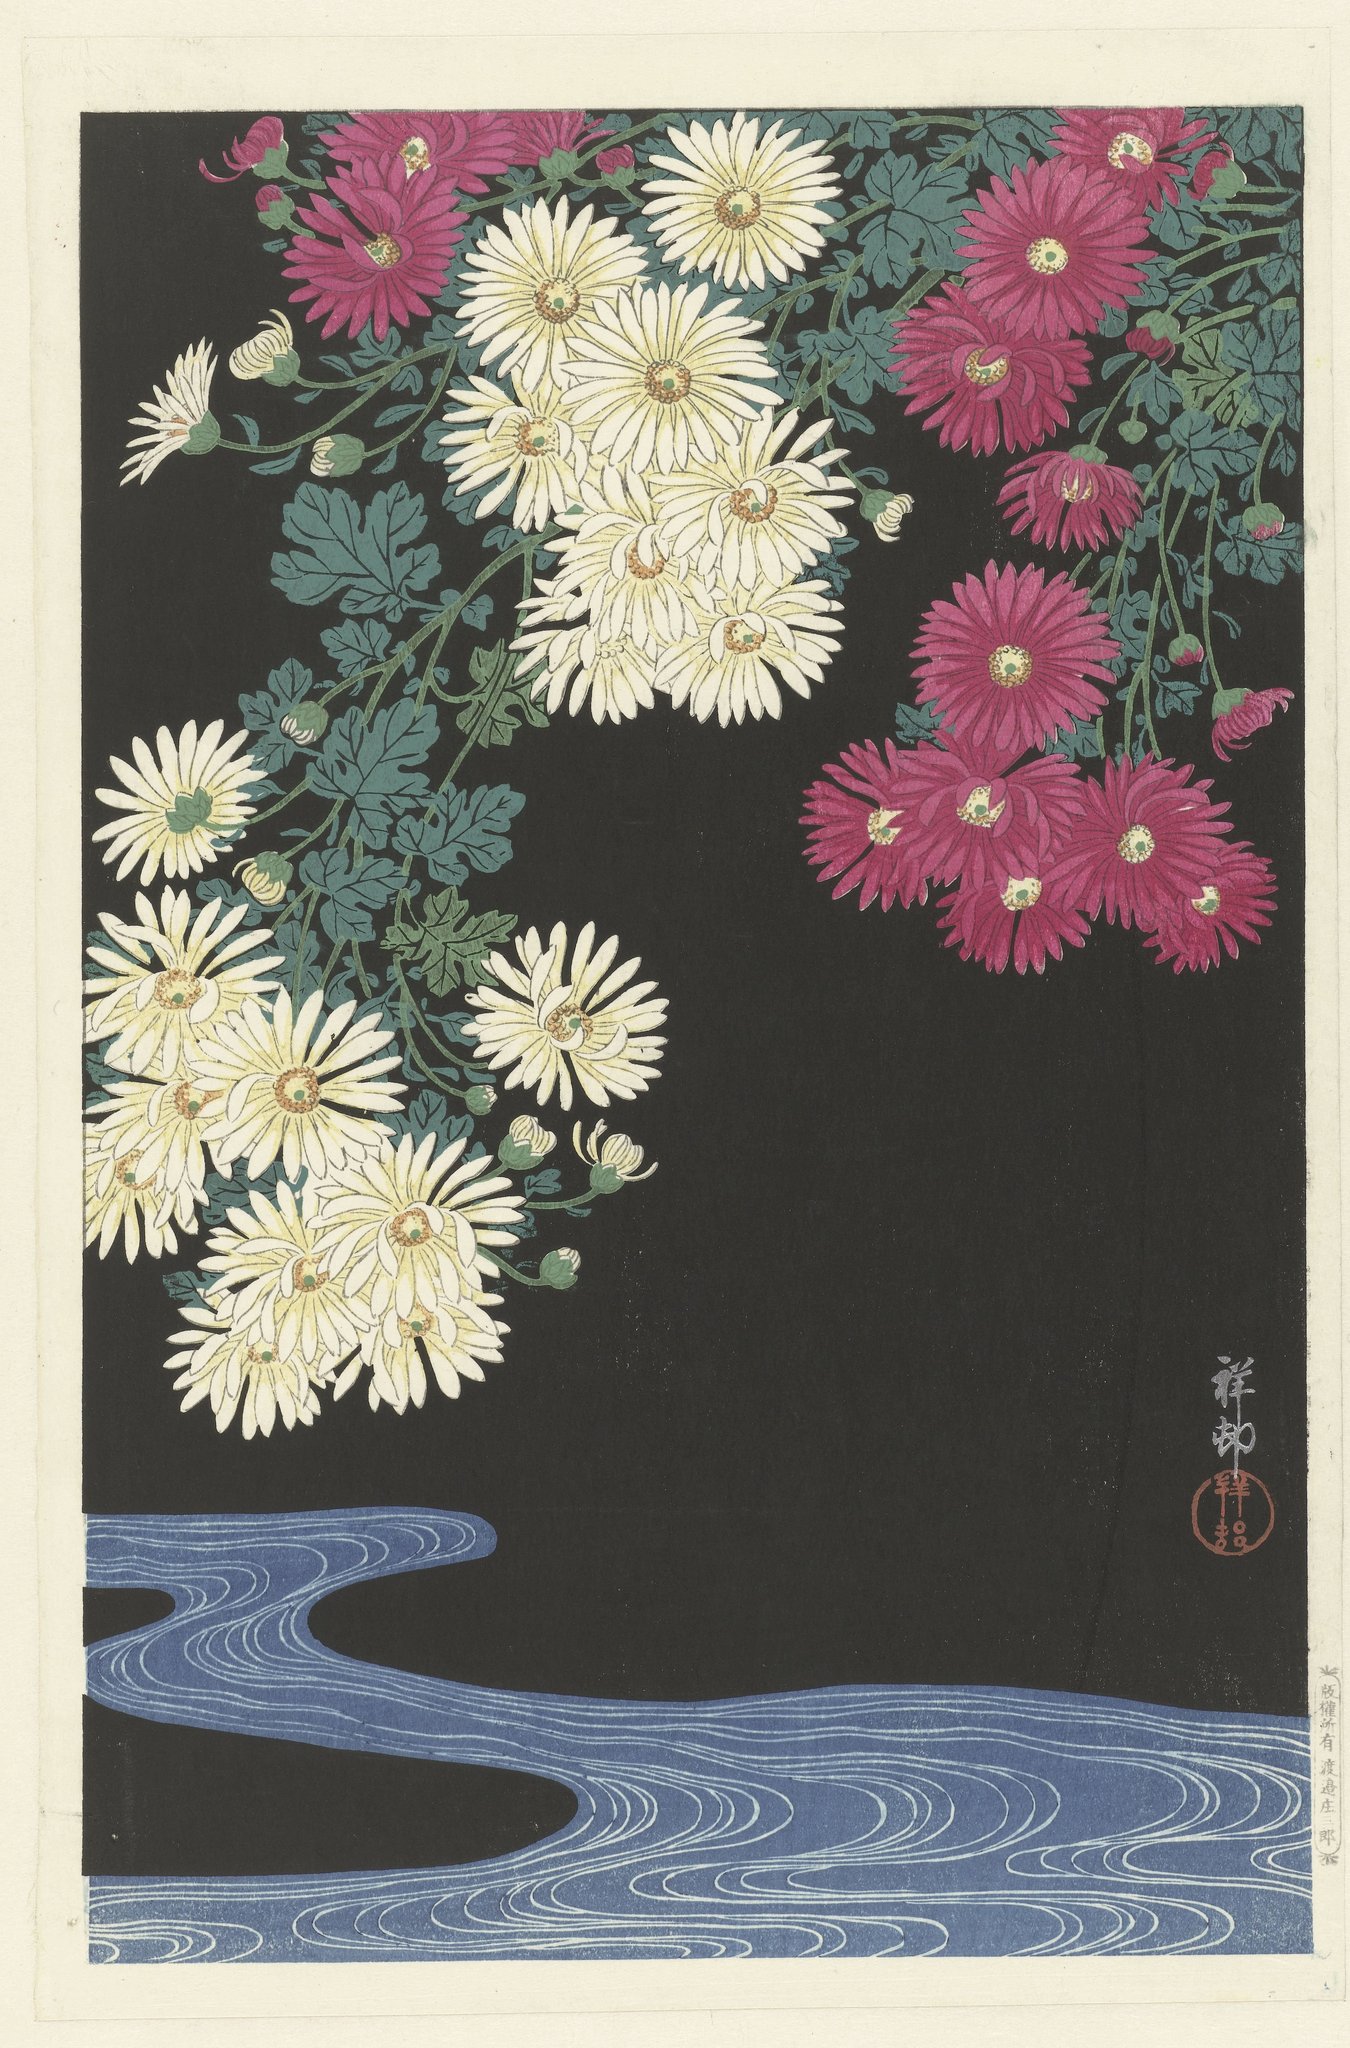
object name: print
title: Chrysanthemums and Running Water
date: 1925-1936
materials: paper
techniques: woodcut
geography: tokyo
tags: flowers, night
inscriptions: collector's mark: Lugt 2228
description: Witte en roze chrysanten boven stromend water; tegen zwarte achtergrond.